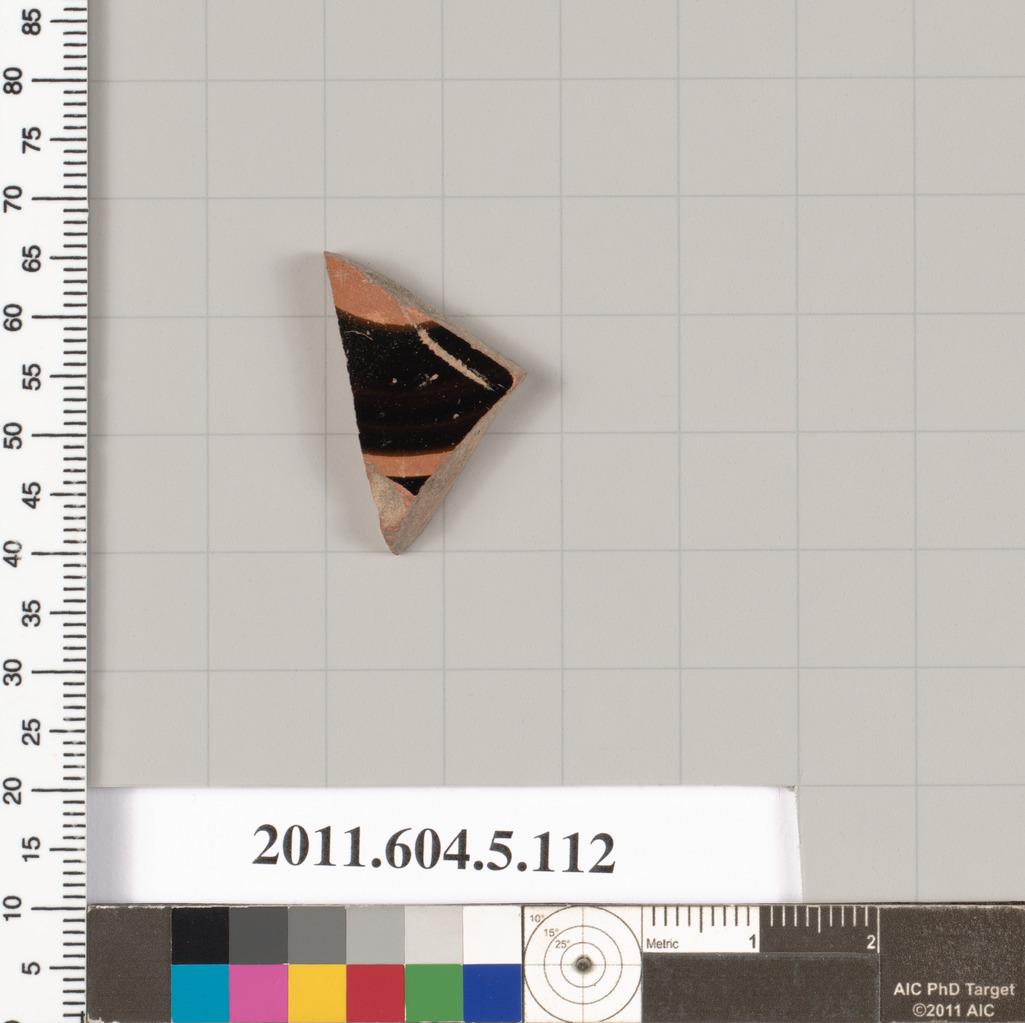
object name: kylix fragment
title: Terracotta fragment of a stemless kylix (drinking cup)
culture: greek, attic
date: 470-450 BCE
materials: terracotta